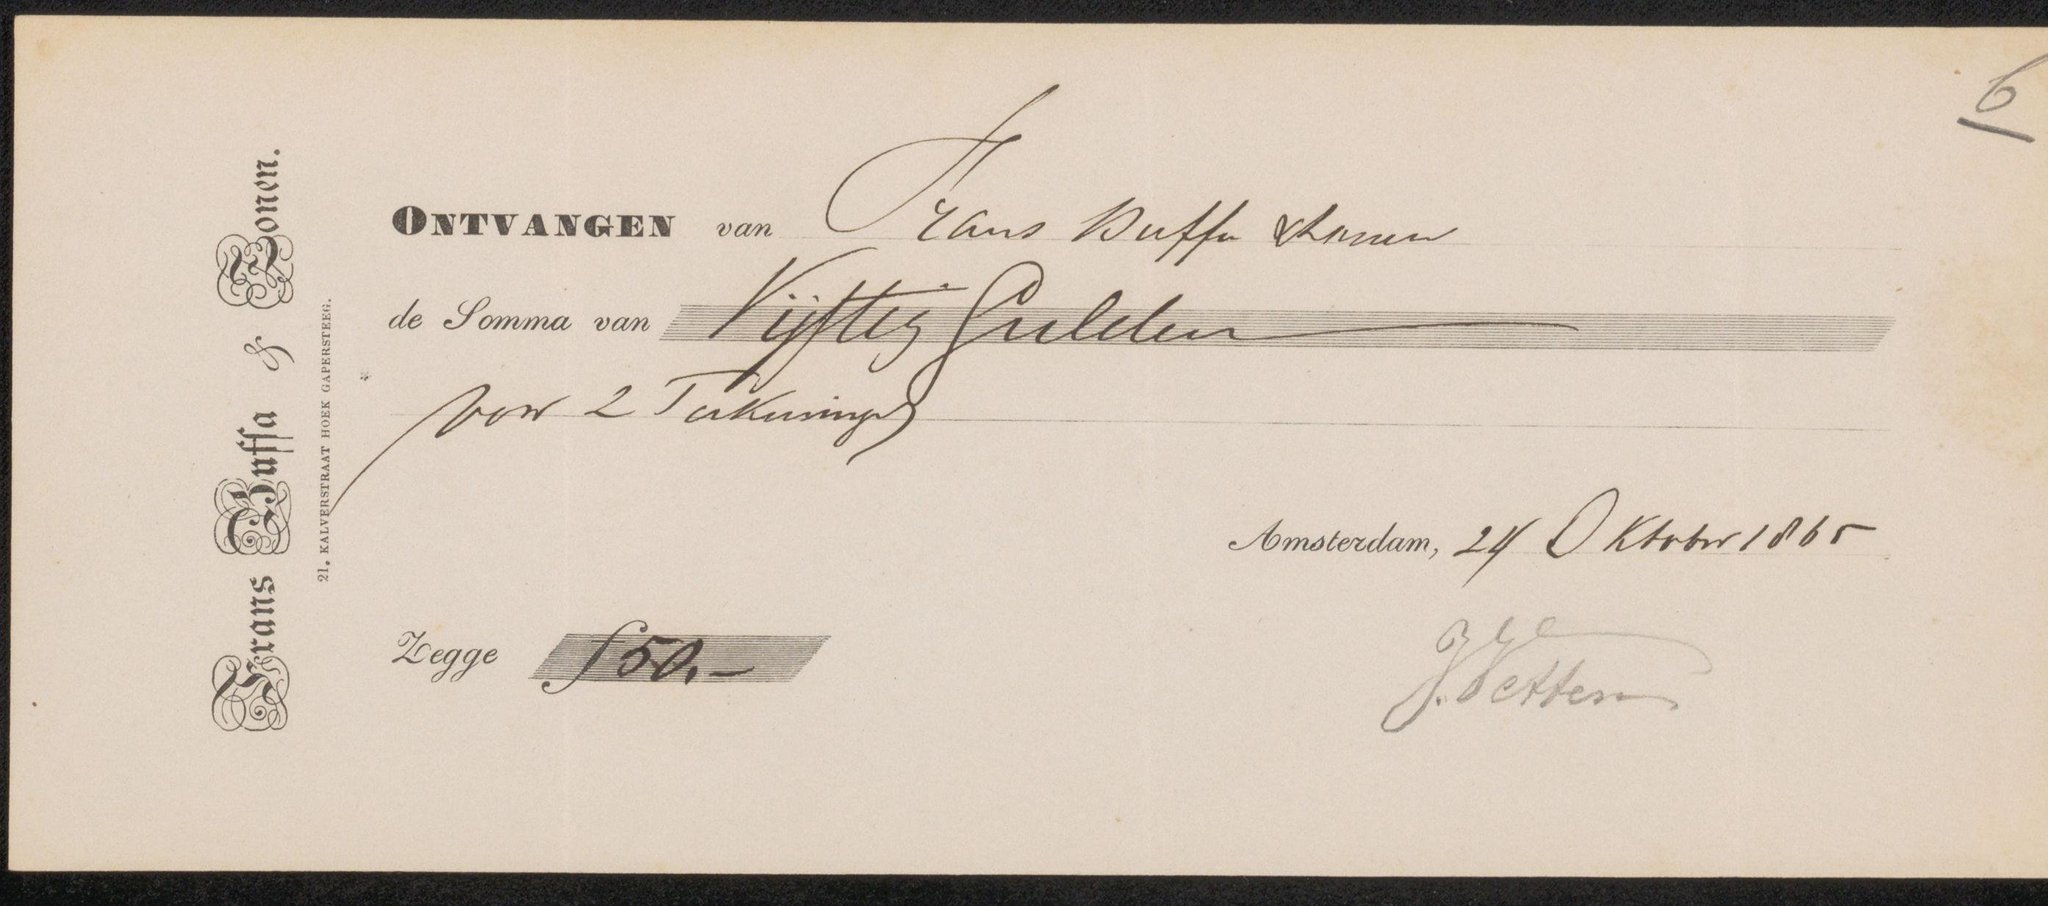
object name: ontvangstbewijs, kwitantie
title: Kwitantie voor Johannes Vetten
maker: johannes vetten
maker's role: painter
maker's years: 1827-1866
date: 1865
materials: ink, paper, pencil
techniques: pen, printing, writing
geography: amsterdam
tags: drawing, money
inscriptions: collector's mark: Lugt 2233